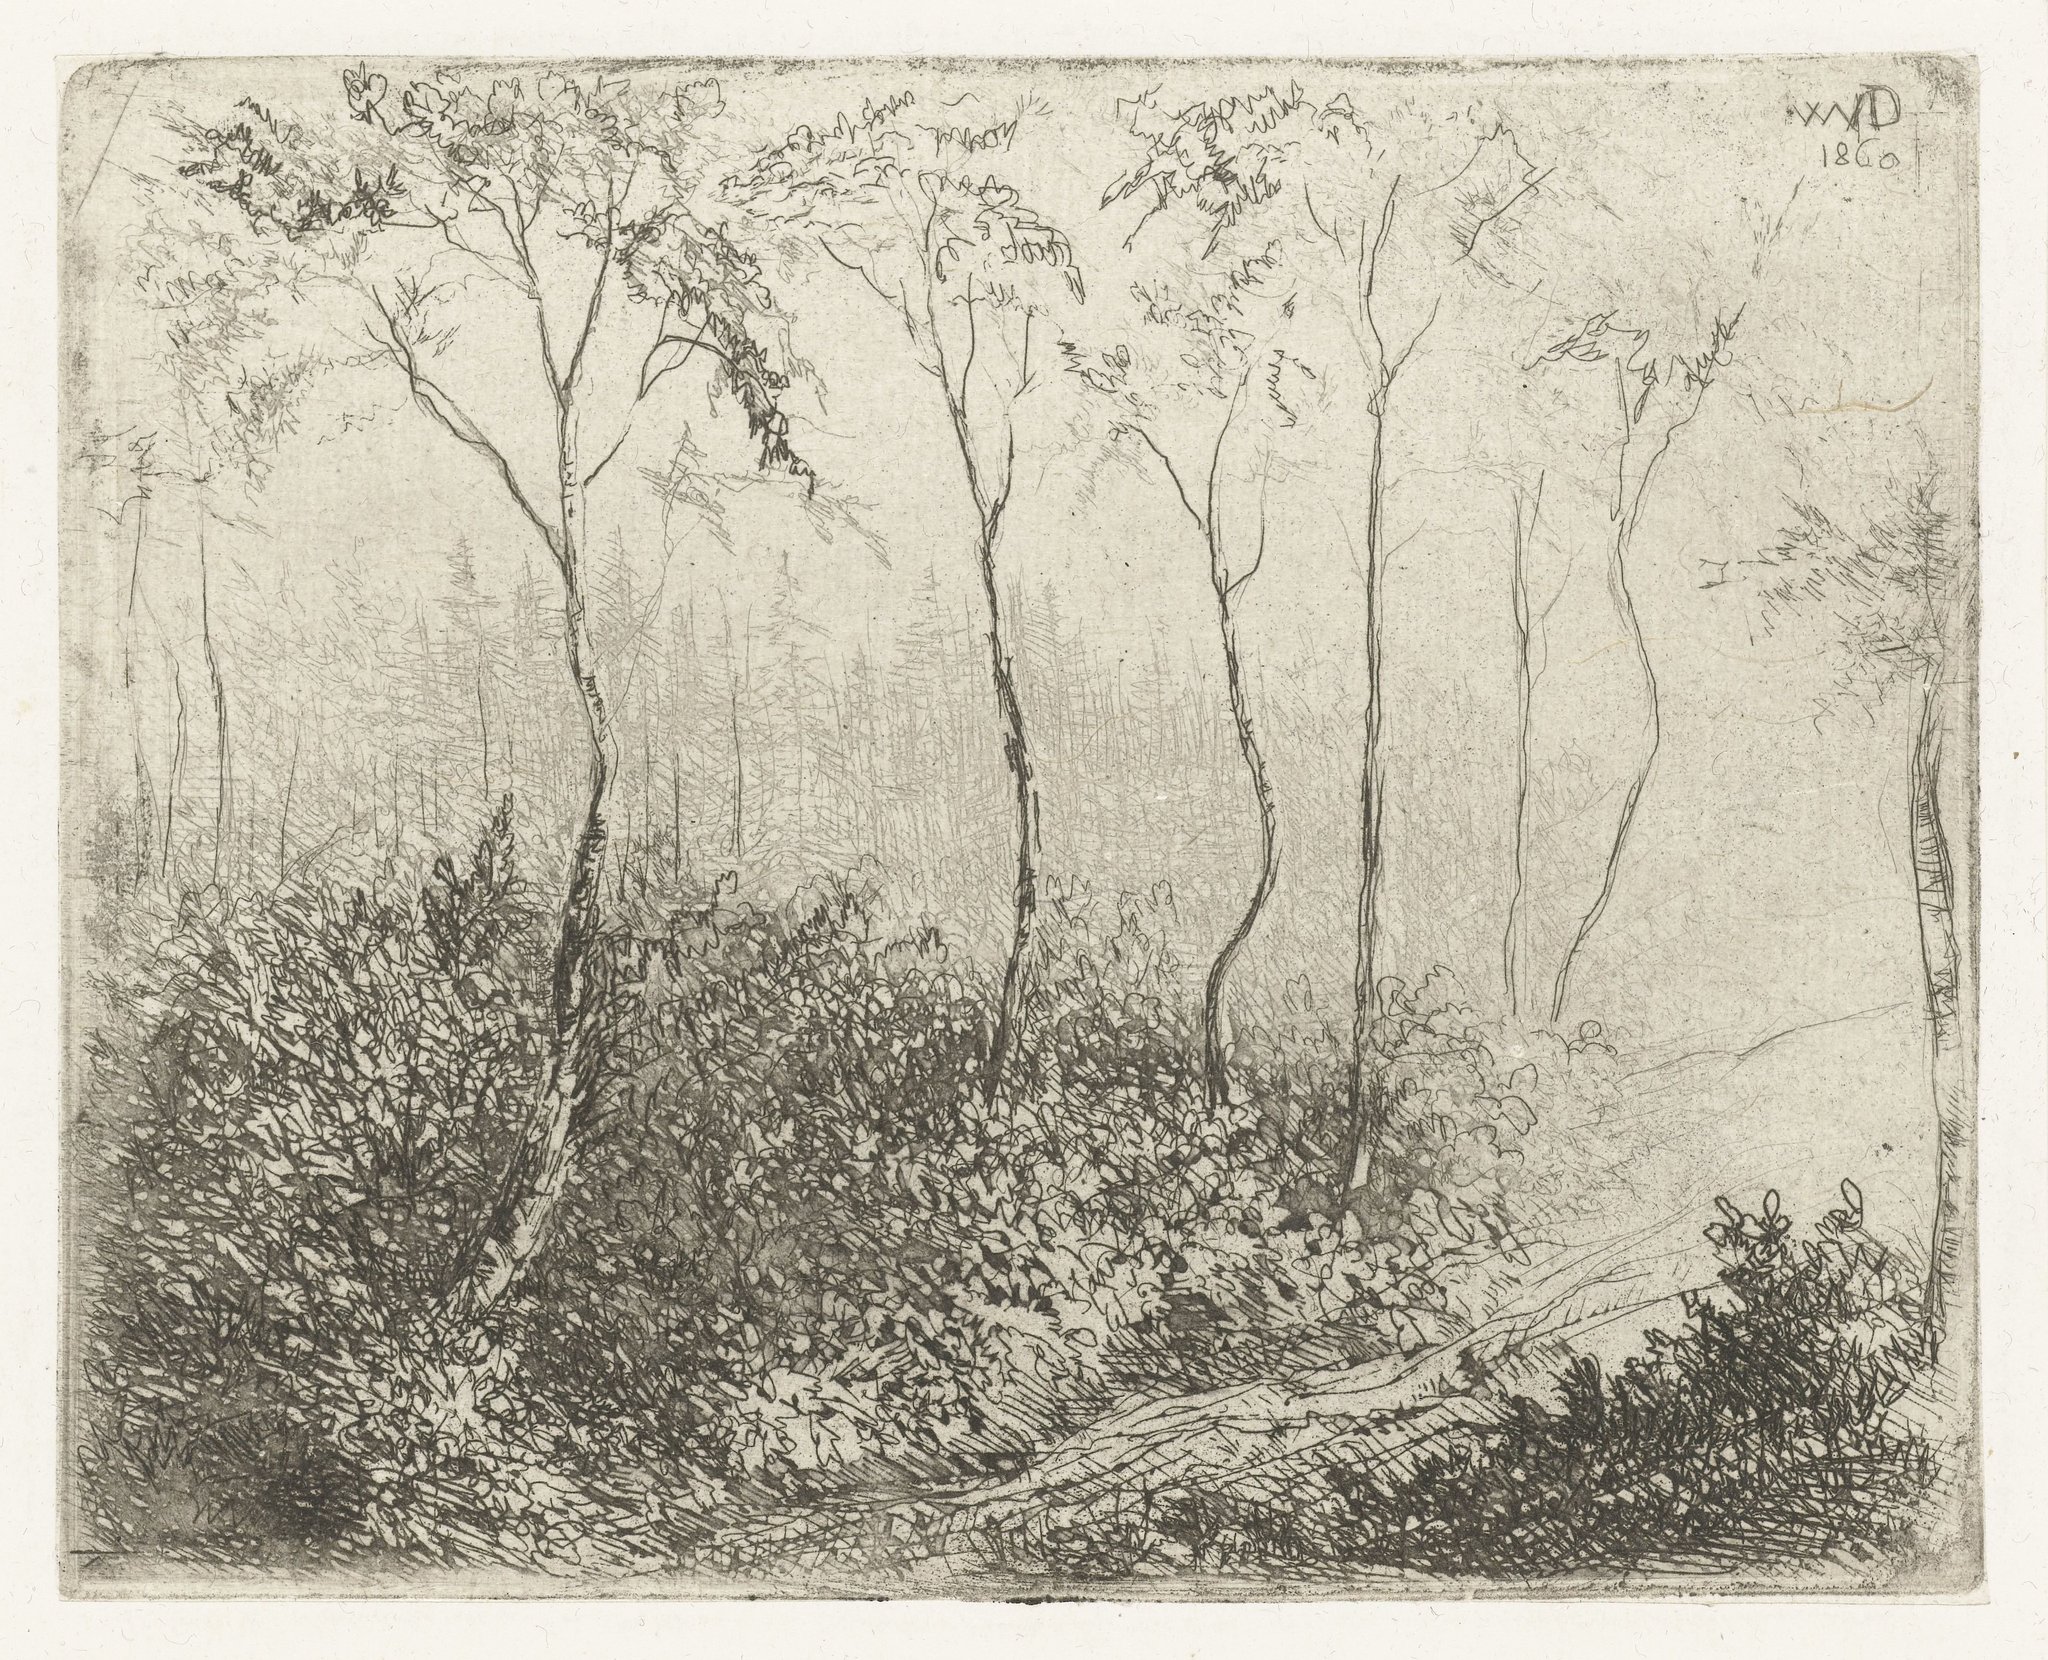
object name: print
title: Boslandschap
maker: willem matthias jan van dielen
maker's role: print maker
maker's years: 1805-1867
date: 1860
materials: paper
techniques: etching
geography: netherlands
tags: forest, wood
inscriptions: collector's mark: Lugt 2228